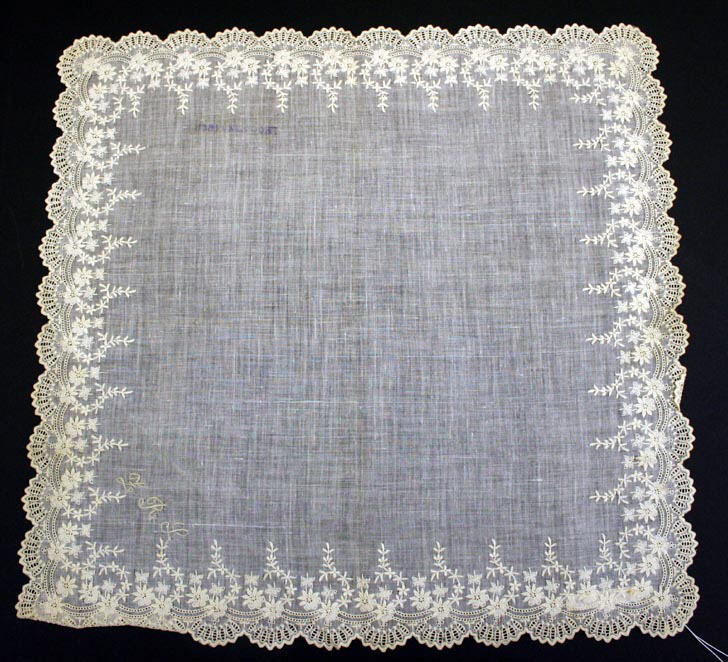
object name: handkerchief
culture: american or european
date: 1888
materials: cotton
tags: flowers